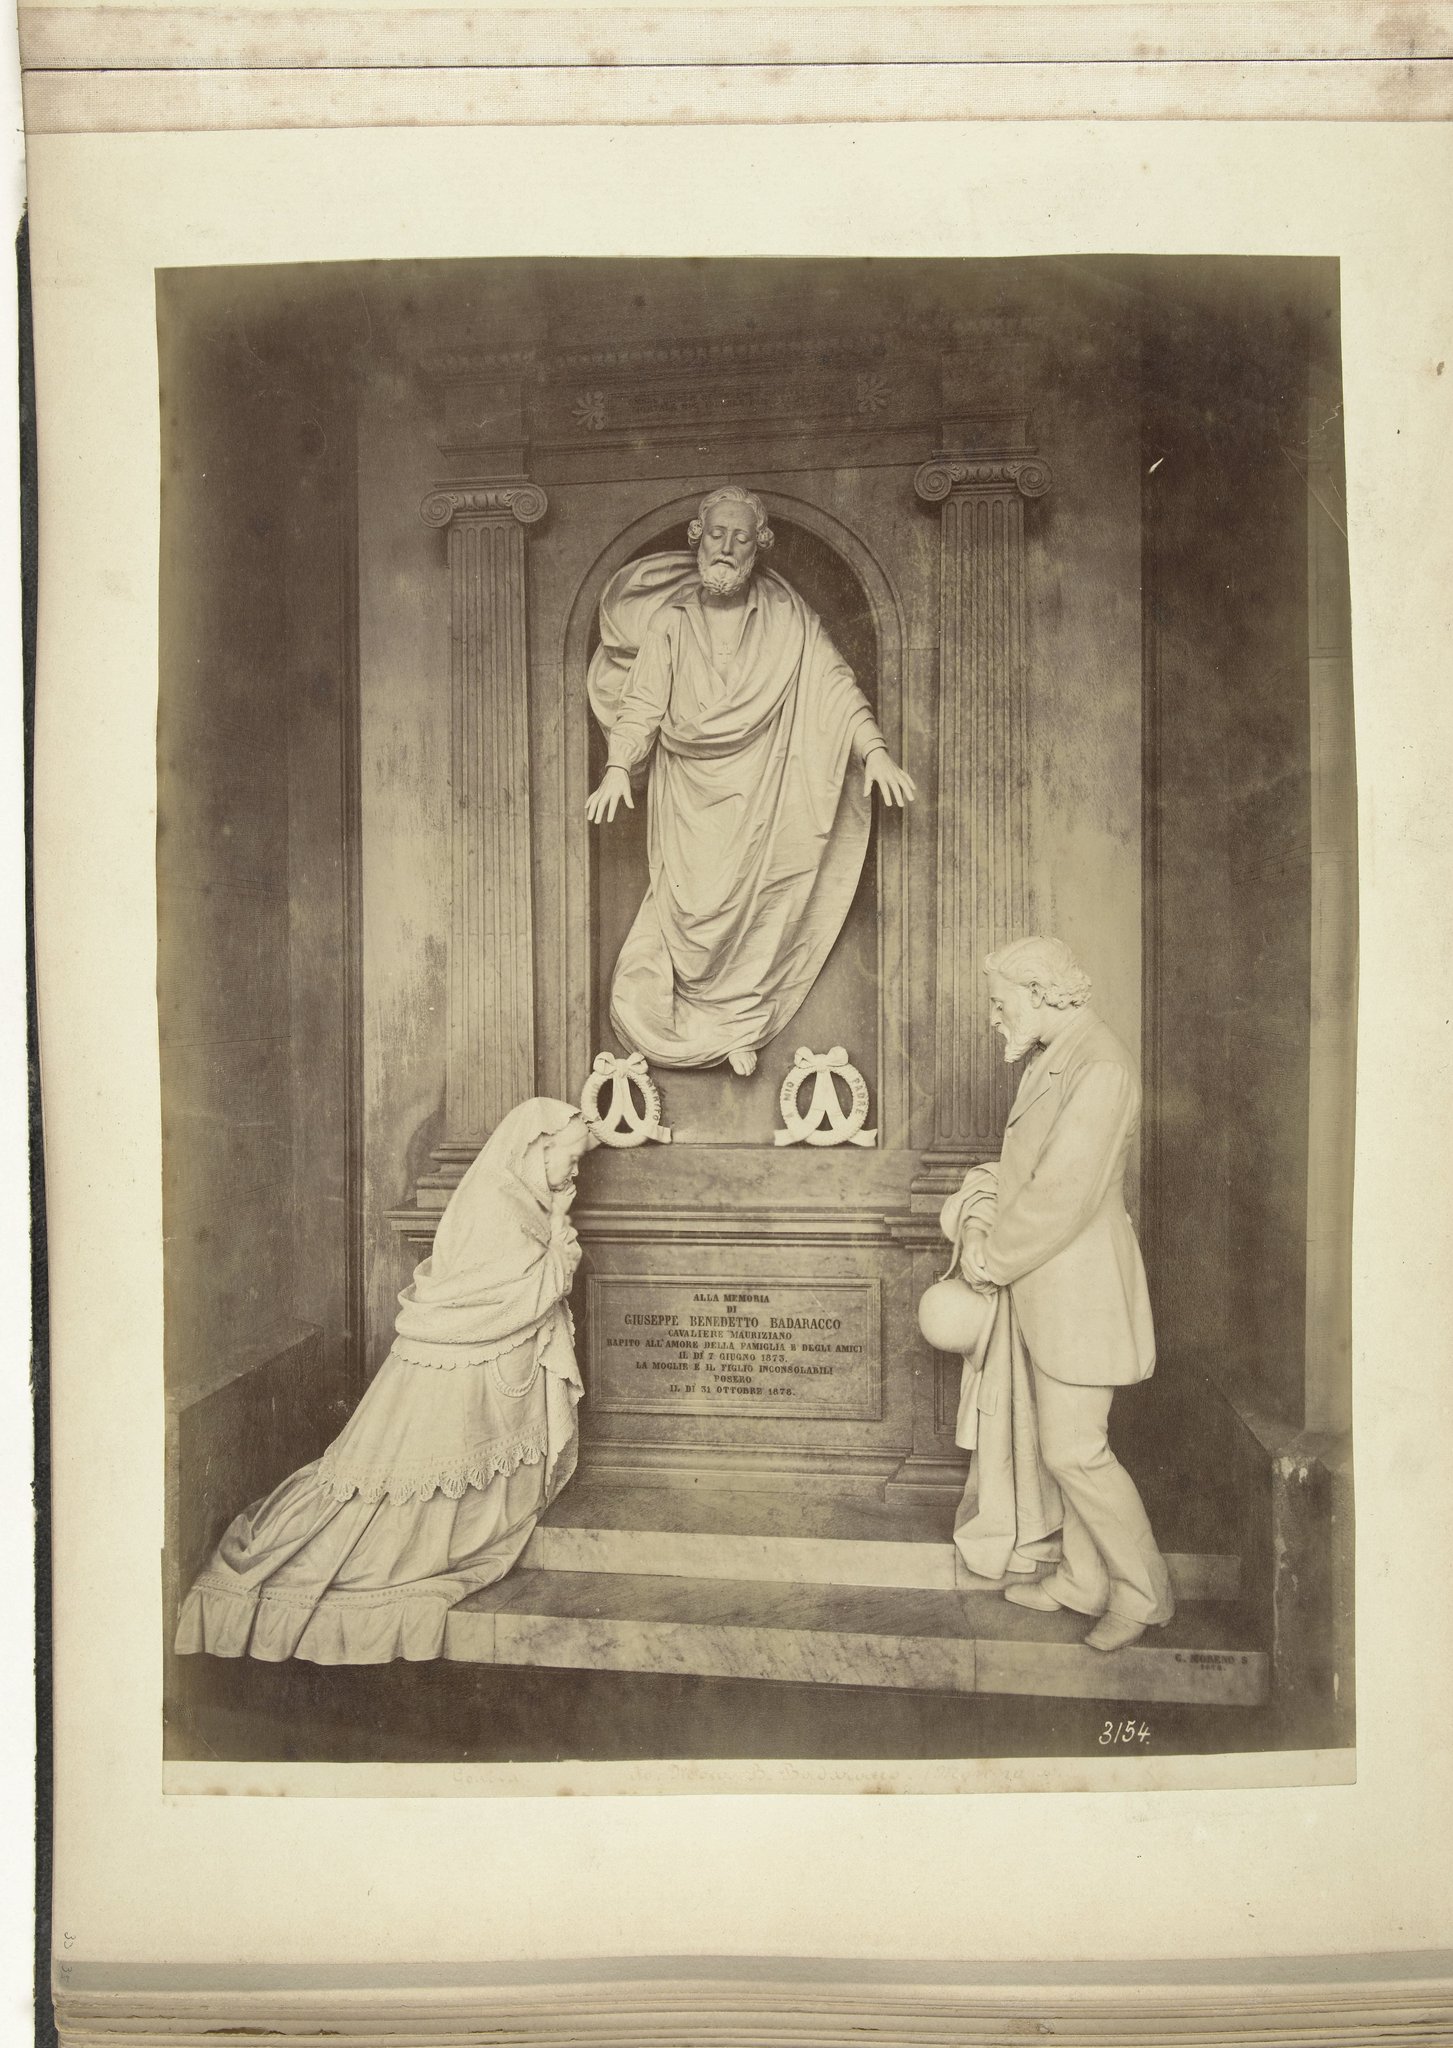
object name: photograph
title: Grafmonument op de Camposanto te Genua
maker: alfredo noack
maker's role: fotograaf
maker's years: 1833-1895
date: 1875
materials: paper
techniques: albumen print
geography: genoa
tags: grave-building, monumental tomb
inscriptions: number: ‘3154.’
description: Een man en vrouw bij het graf van hun overleden kind, boven het graf waakt de heer. Grafmomunument van Guiseppe Benedetto Badaracco, vervaardigd door Moreno.